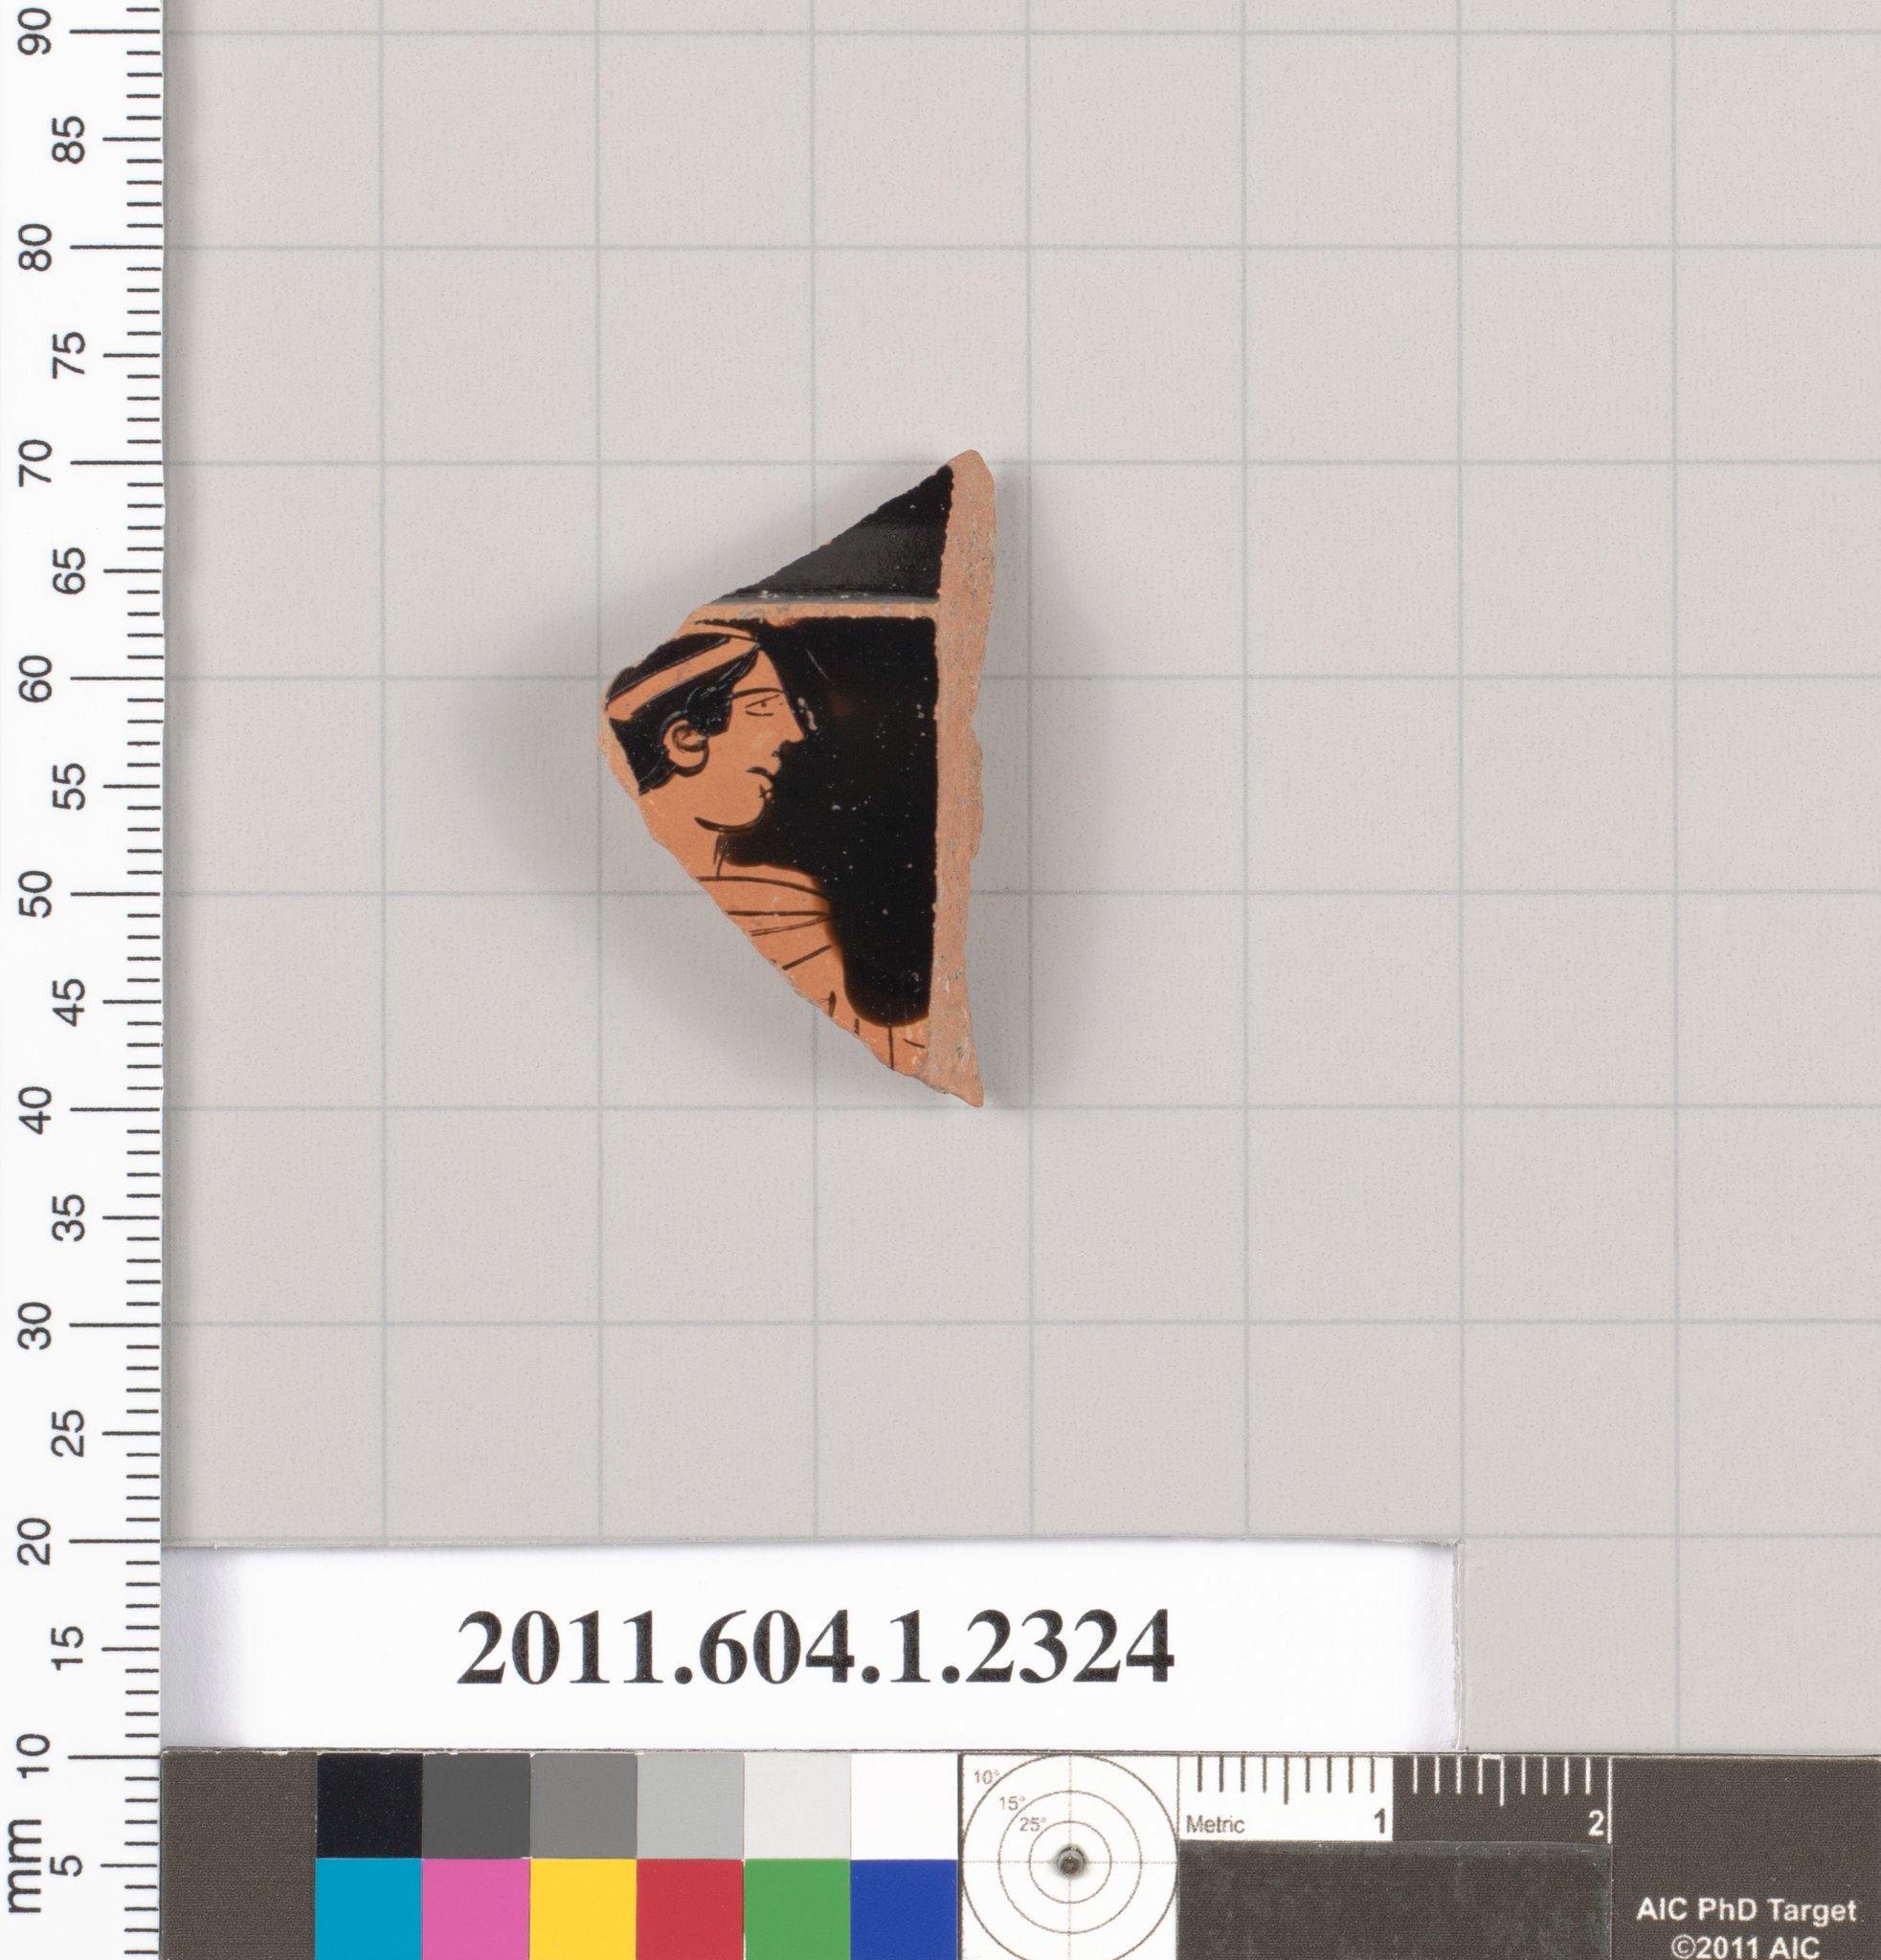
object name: kylix fragment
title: Terracotta fragment of a kylix (drinking cup)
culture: greek, attic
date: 467-435 BCE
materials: terracotta